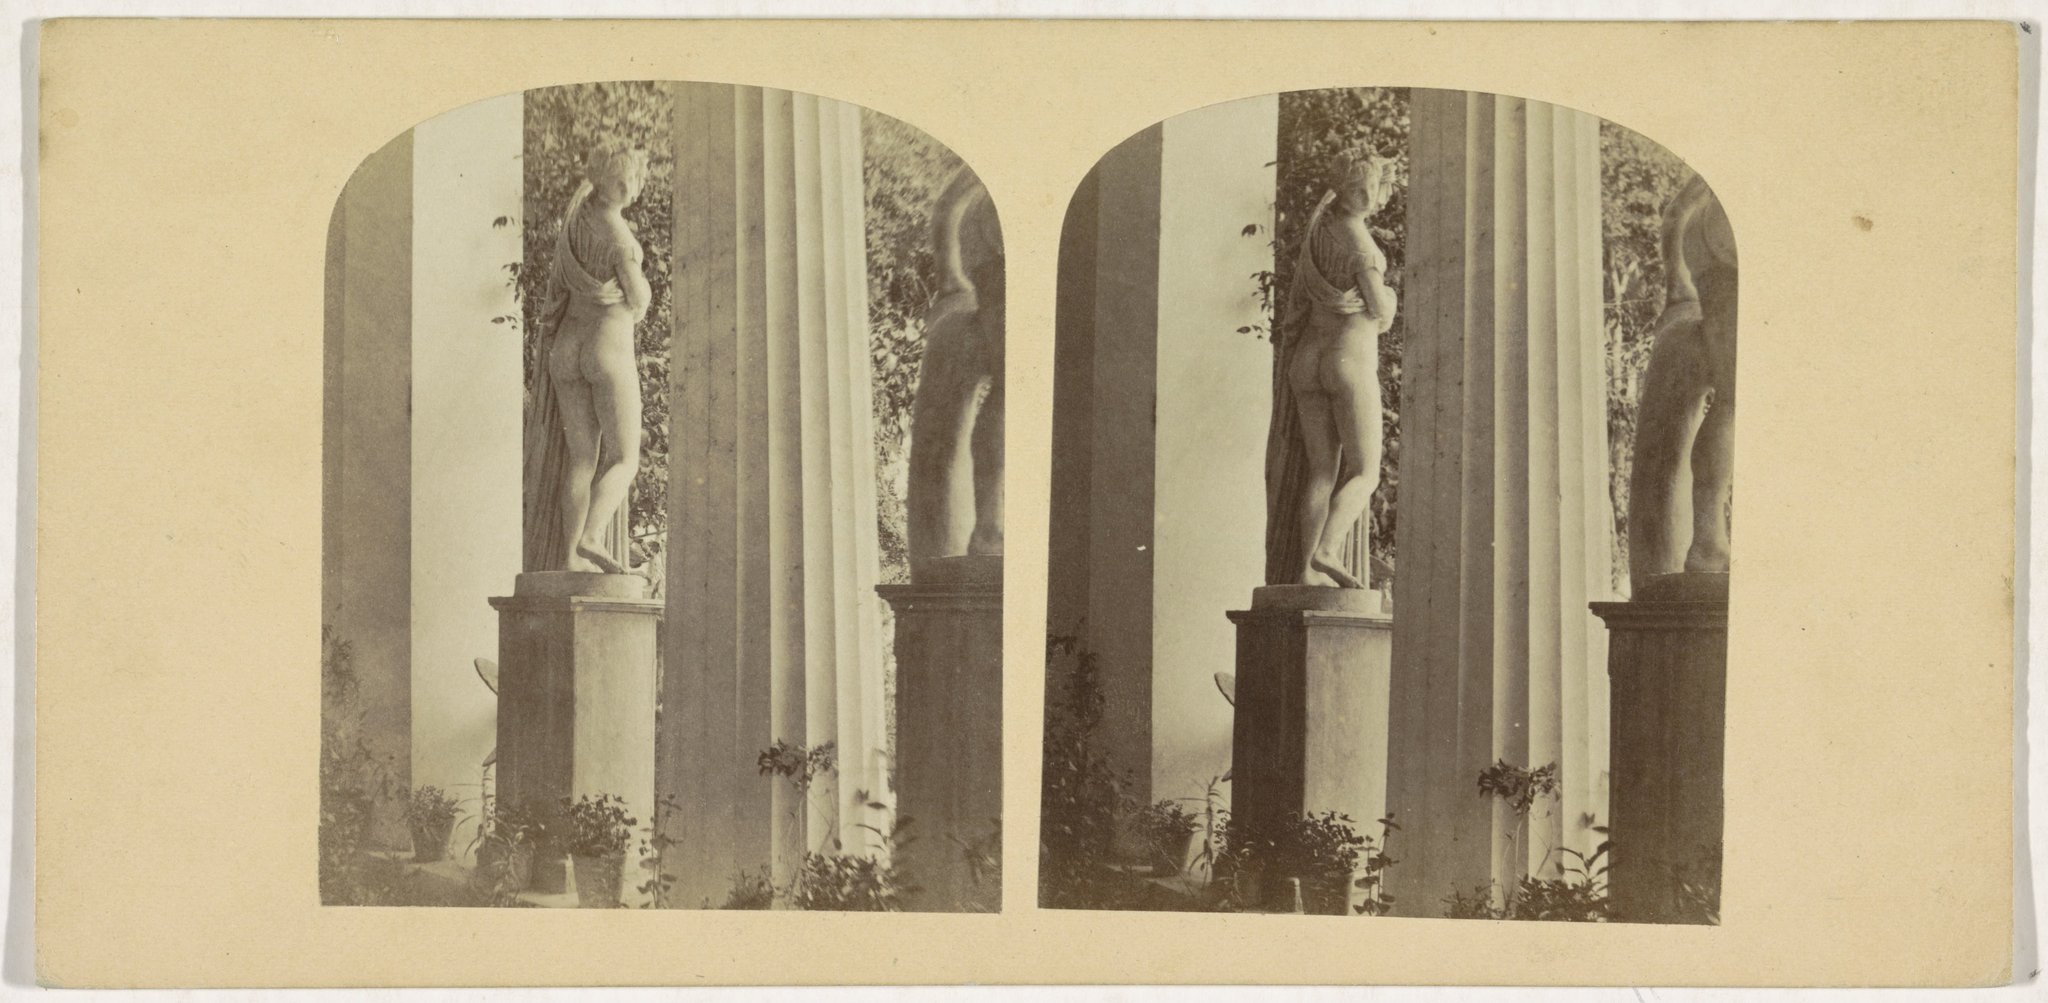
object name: stereograph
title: Beeldhouwwerk van Venus in een zuilengalerij (?) van de Villa Campana, Rome (?)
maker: Anonymous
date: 1855-1865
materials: cardboard, paper, photographic support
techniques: albumen print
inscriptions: inscription: ‘Venus euhpyge (?) villa Campana’